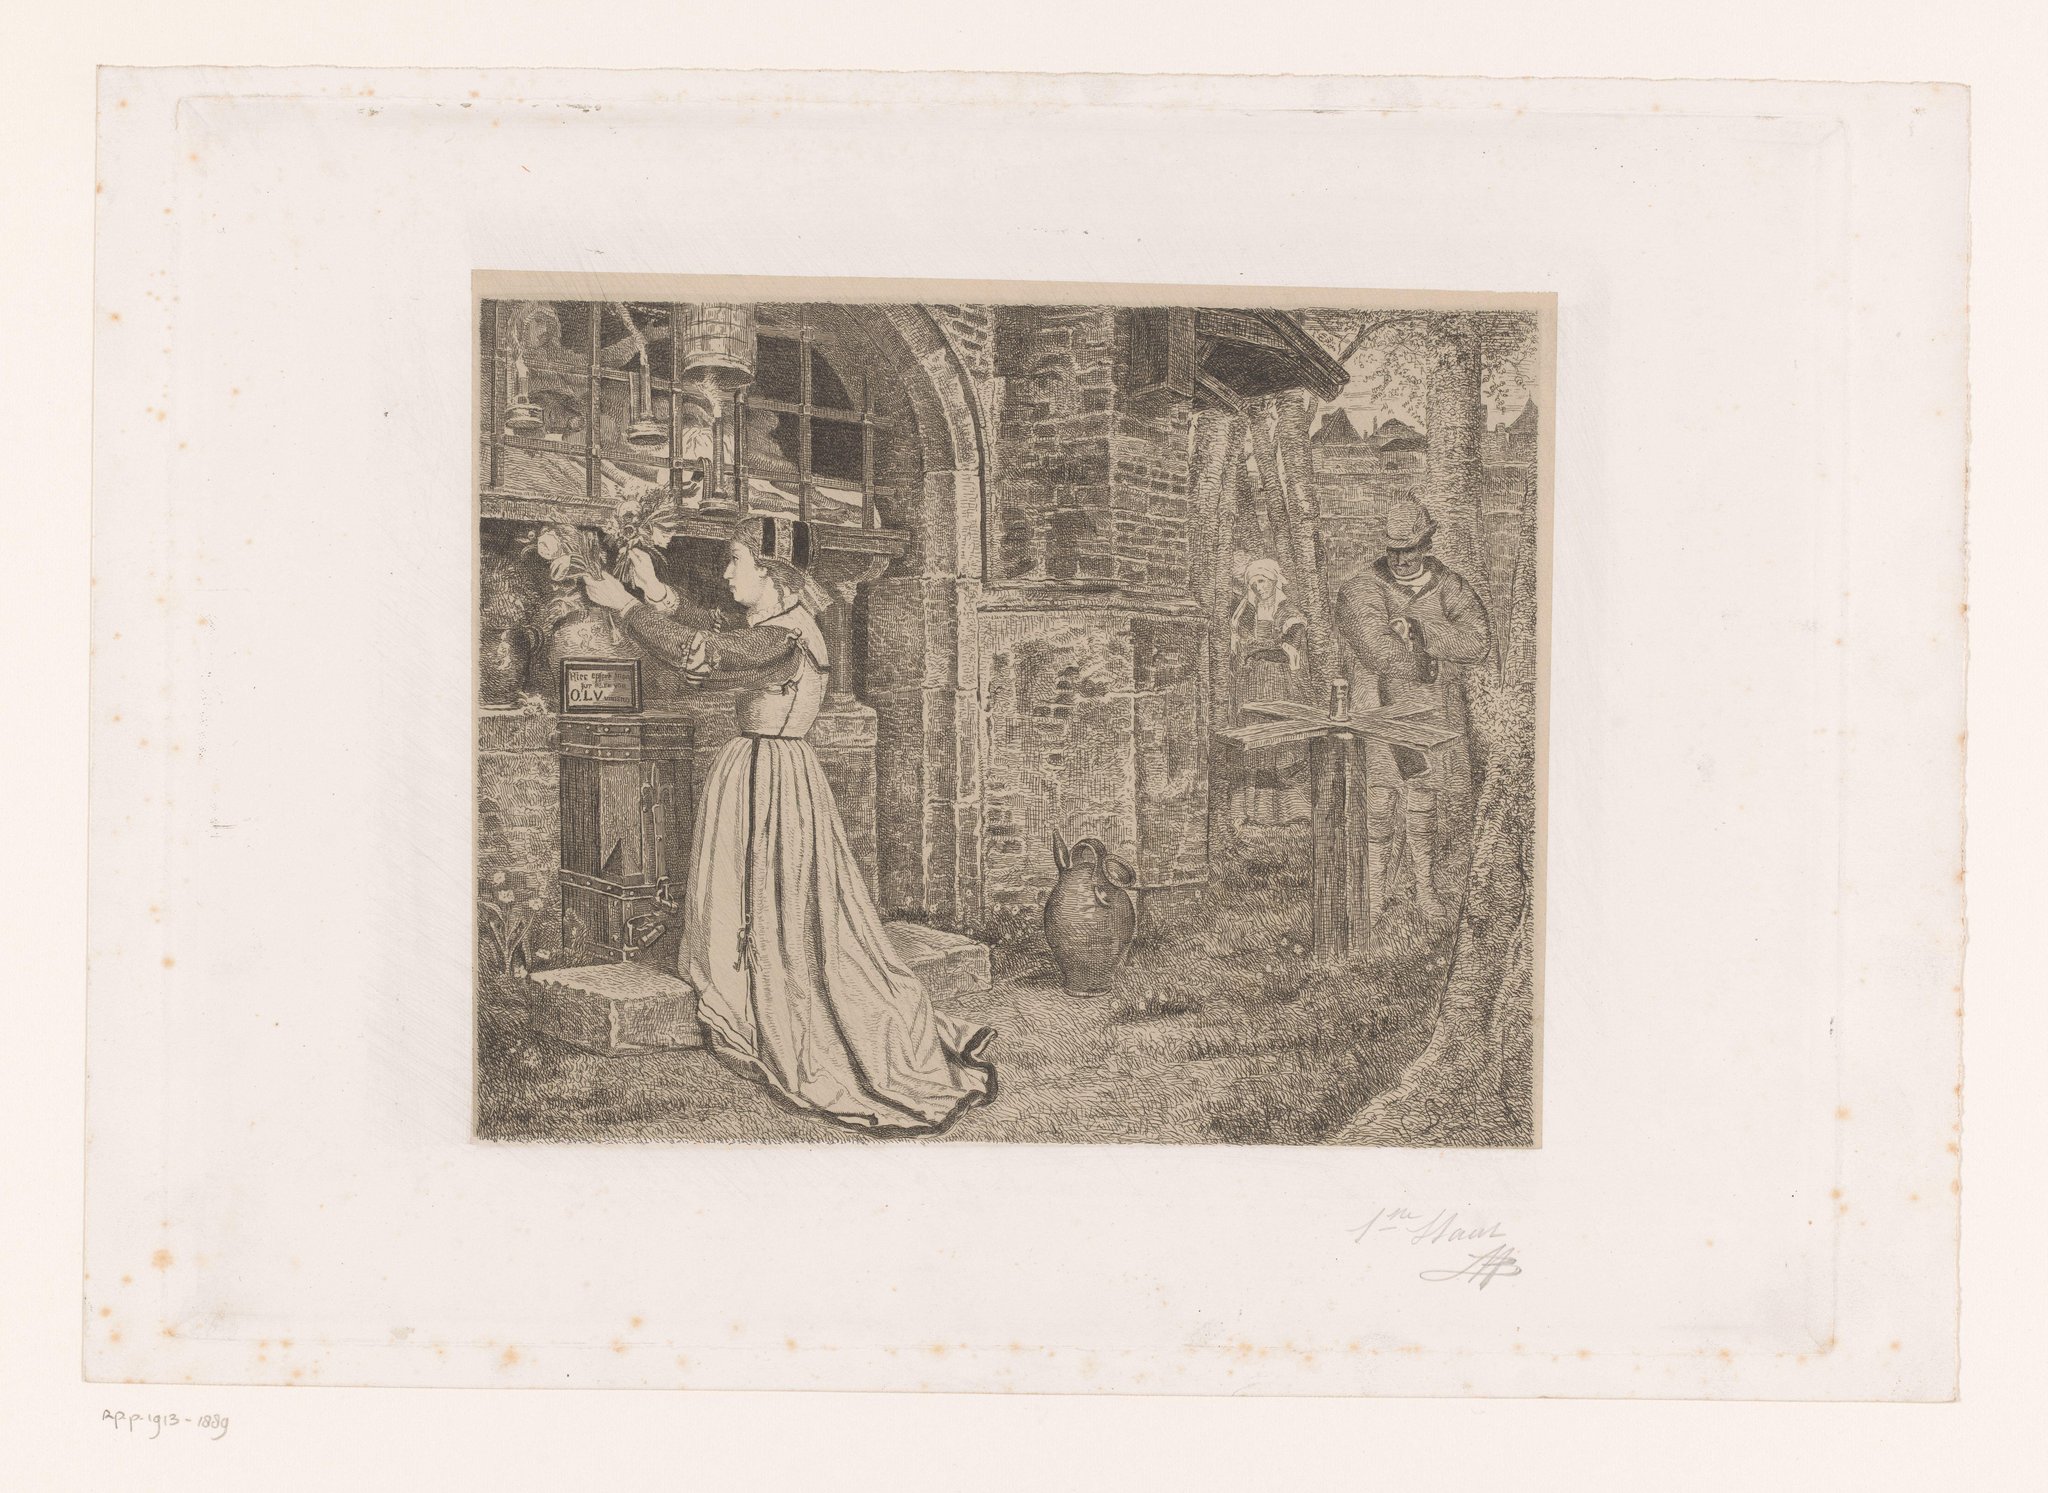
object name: print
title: Faust en Gretchen in een tuin bij een kapel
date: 1831-1890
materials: paper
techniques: etching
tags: faust, (scenes from) specific works of literature: goethe, faust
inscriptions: collector's mark: Lugt 2228, inscription: ‘1ste Staat’